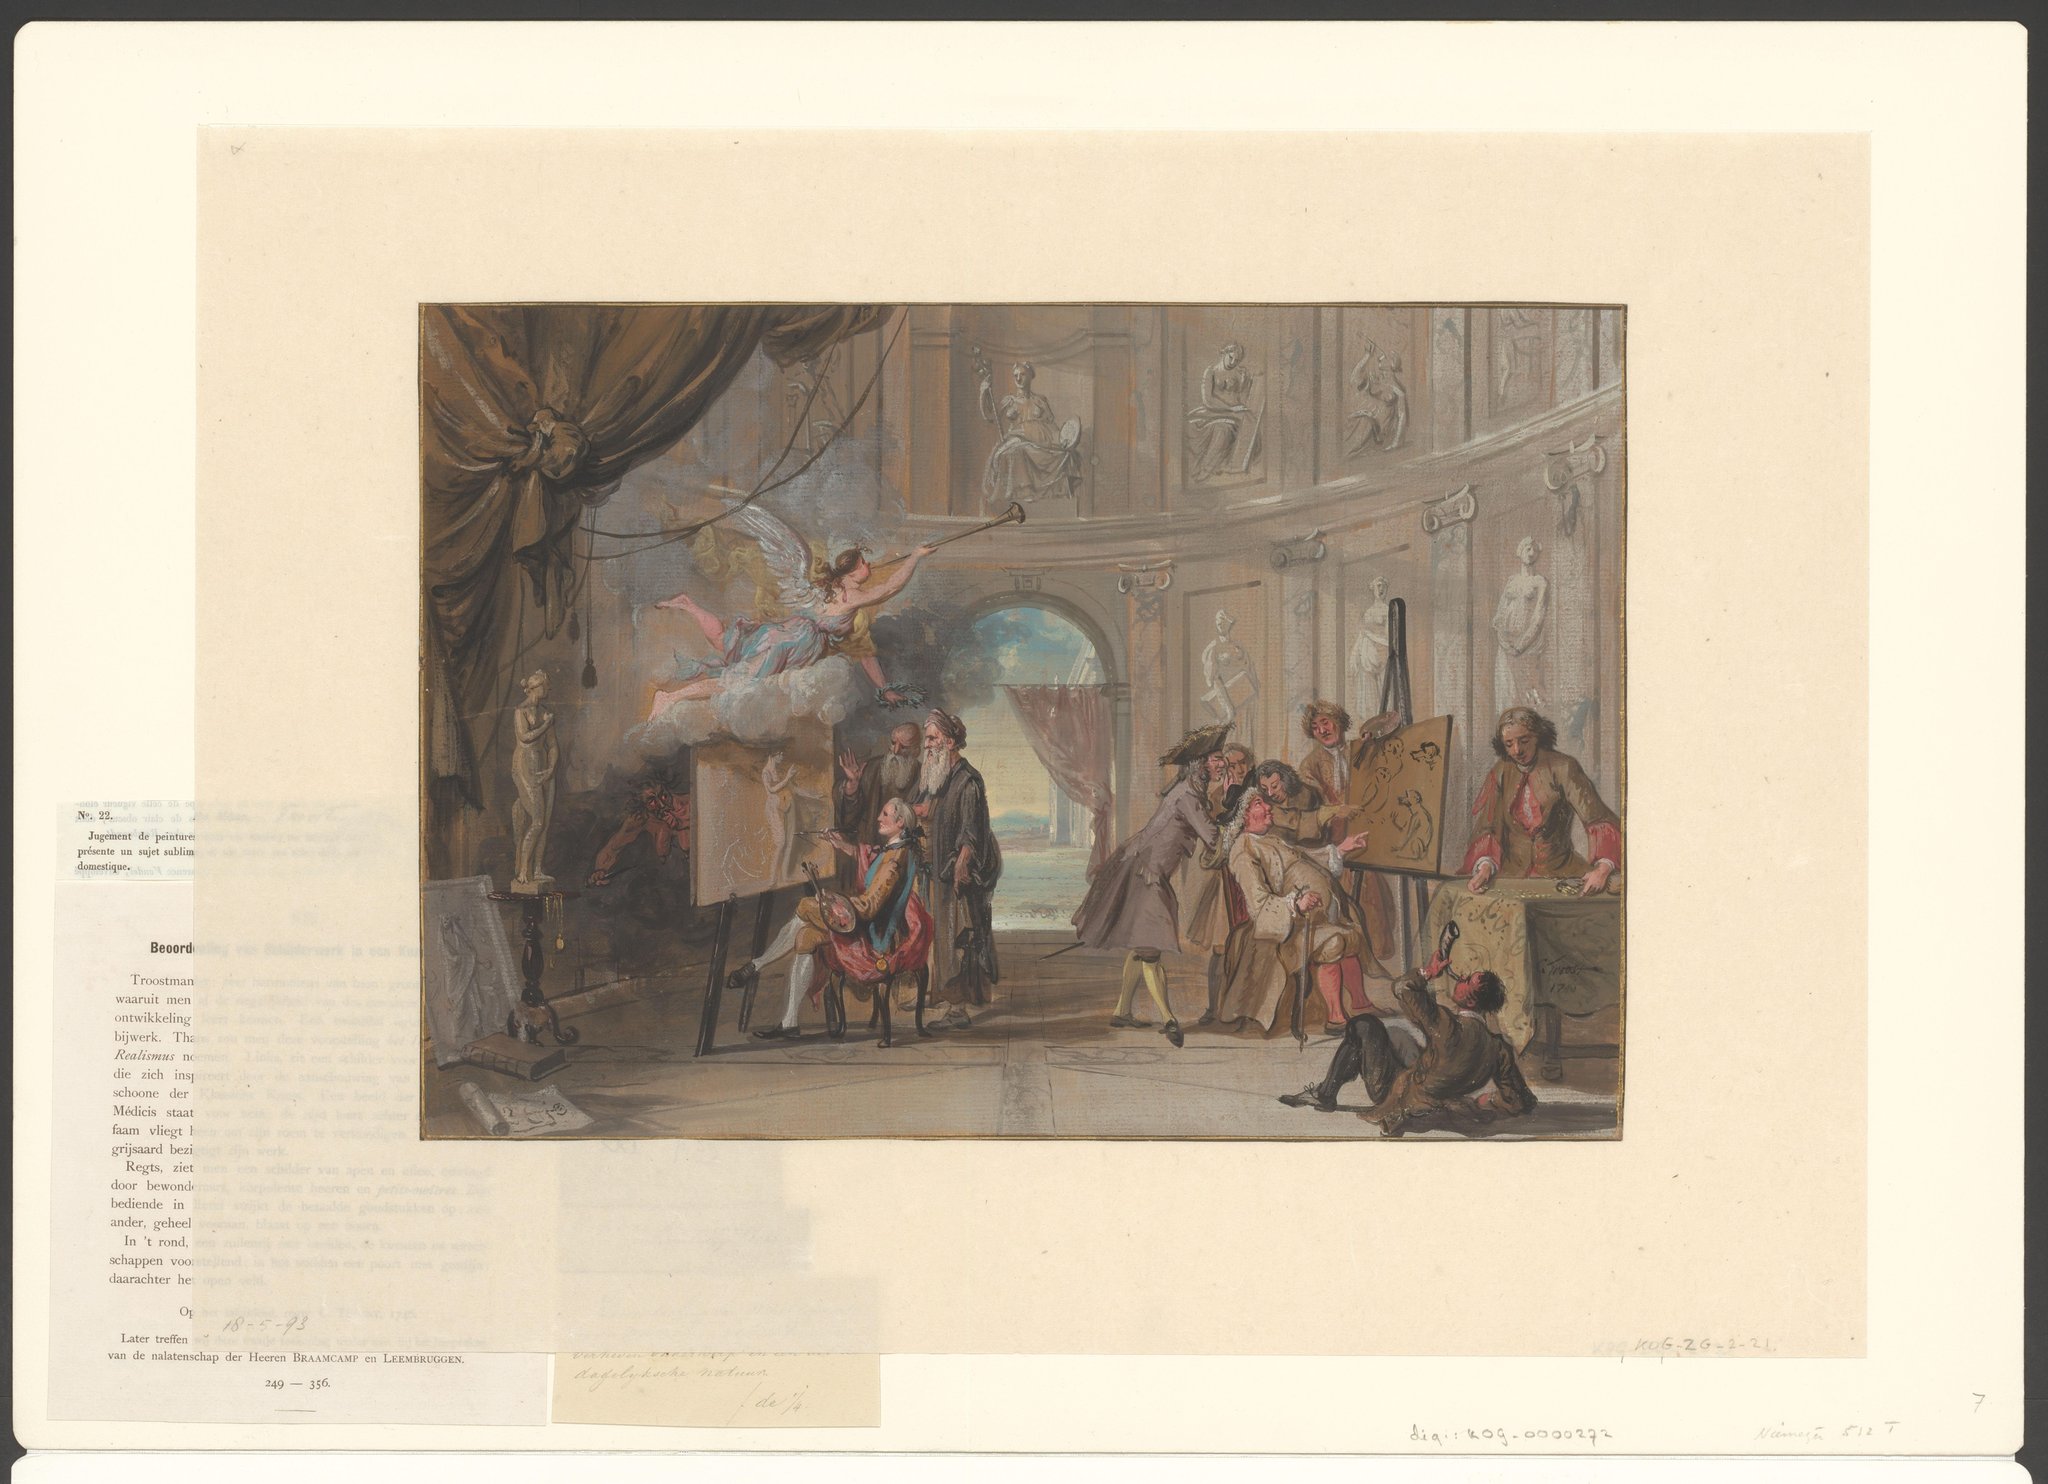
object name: drawing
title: Tweeërlei kunst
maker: cornelis troost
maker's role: draughtsman, painter, print maker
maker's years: 1696-1750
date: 1746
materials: chalk, gouache, paper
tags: drum (musical instrument), painter at work, in his studio, fame; 'fama', 'fama buona', 'fama chiara' (ripa)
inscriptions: collector's mark: Lugt 2488, collector's mark: Lugt 1641a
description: Allegorische voorstelling; in de monumentale hal van een tempel wordt een historieschilder met bewonderaars, die gekroond wordt door Faam. Rechts een schilder van uilen en apen, aan hem worden vele gouden munten betaald.